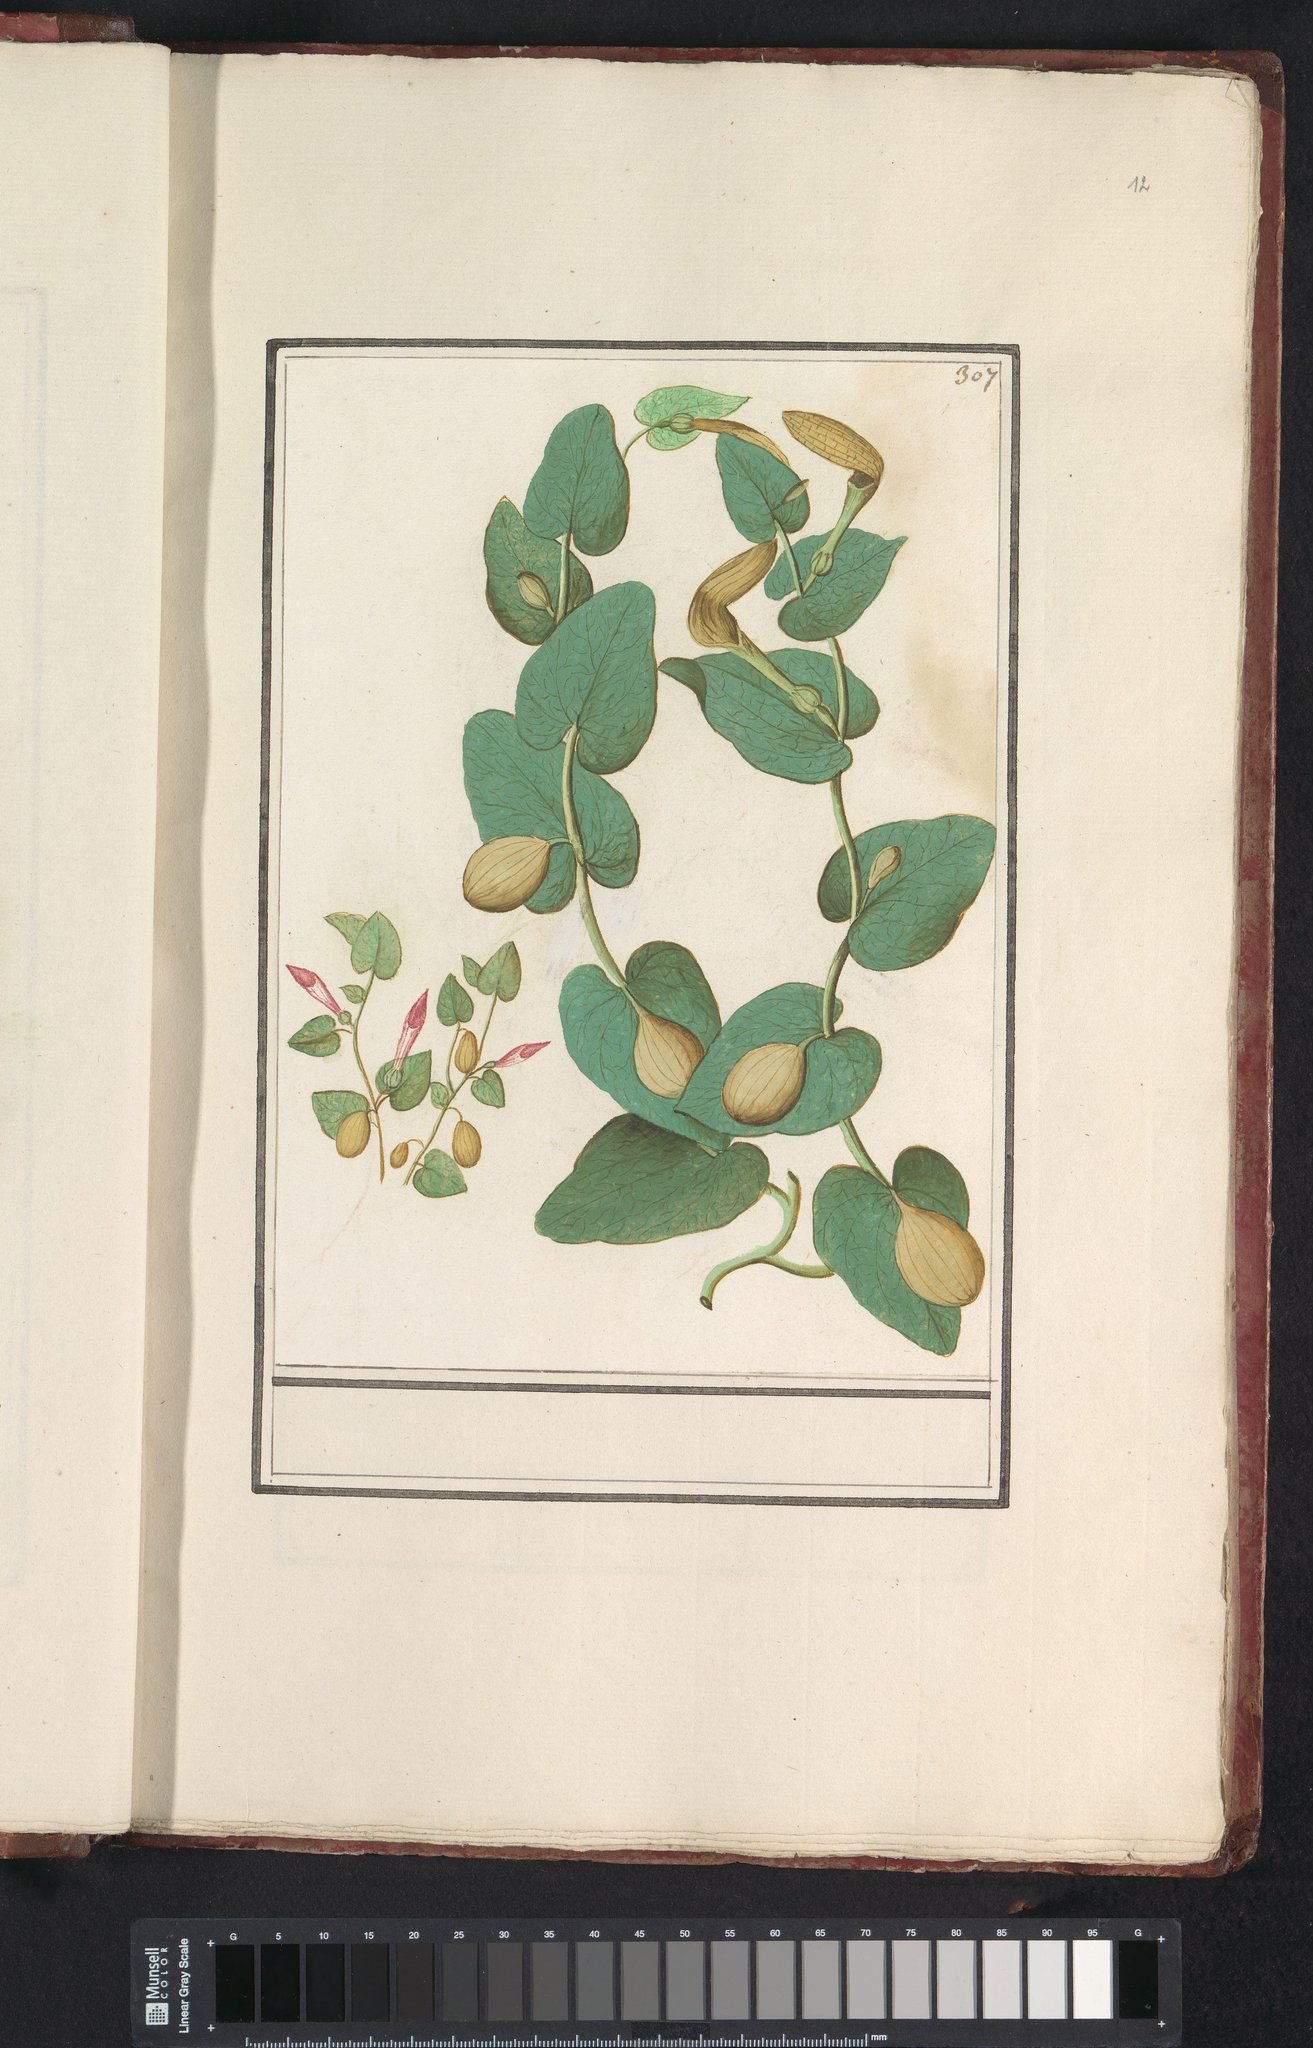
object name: drawing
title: Onbekende plant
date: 1596-1610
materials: chalk, paint, paper, watercolor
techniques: brush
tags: flowers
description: Onbekende plant, mogelijk een plant uit de aronskelkfamilie. Genummerd rechtsboven: 307. Onderdeel van het vierde album met tekeningen van bloemen en paddestoelen. Elfde van twaalf albums met tekeningen van dieren, vogels en planten bekend rond 1600, gemaakt in opdracht van keizer Rudolf II. Met toelichting in Nederlands, Latijn en Frans.